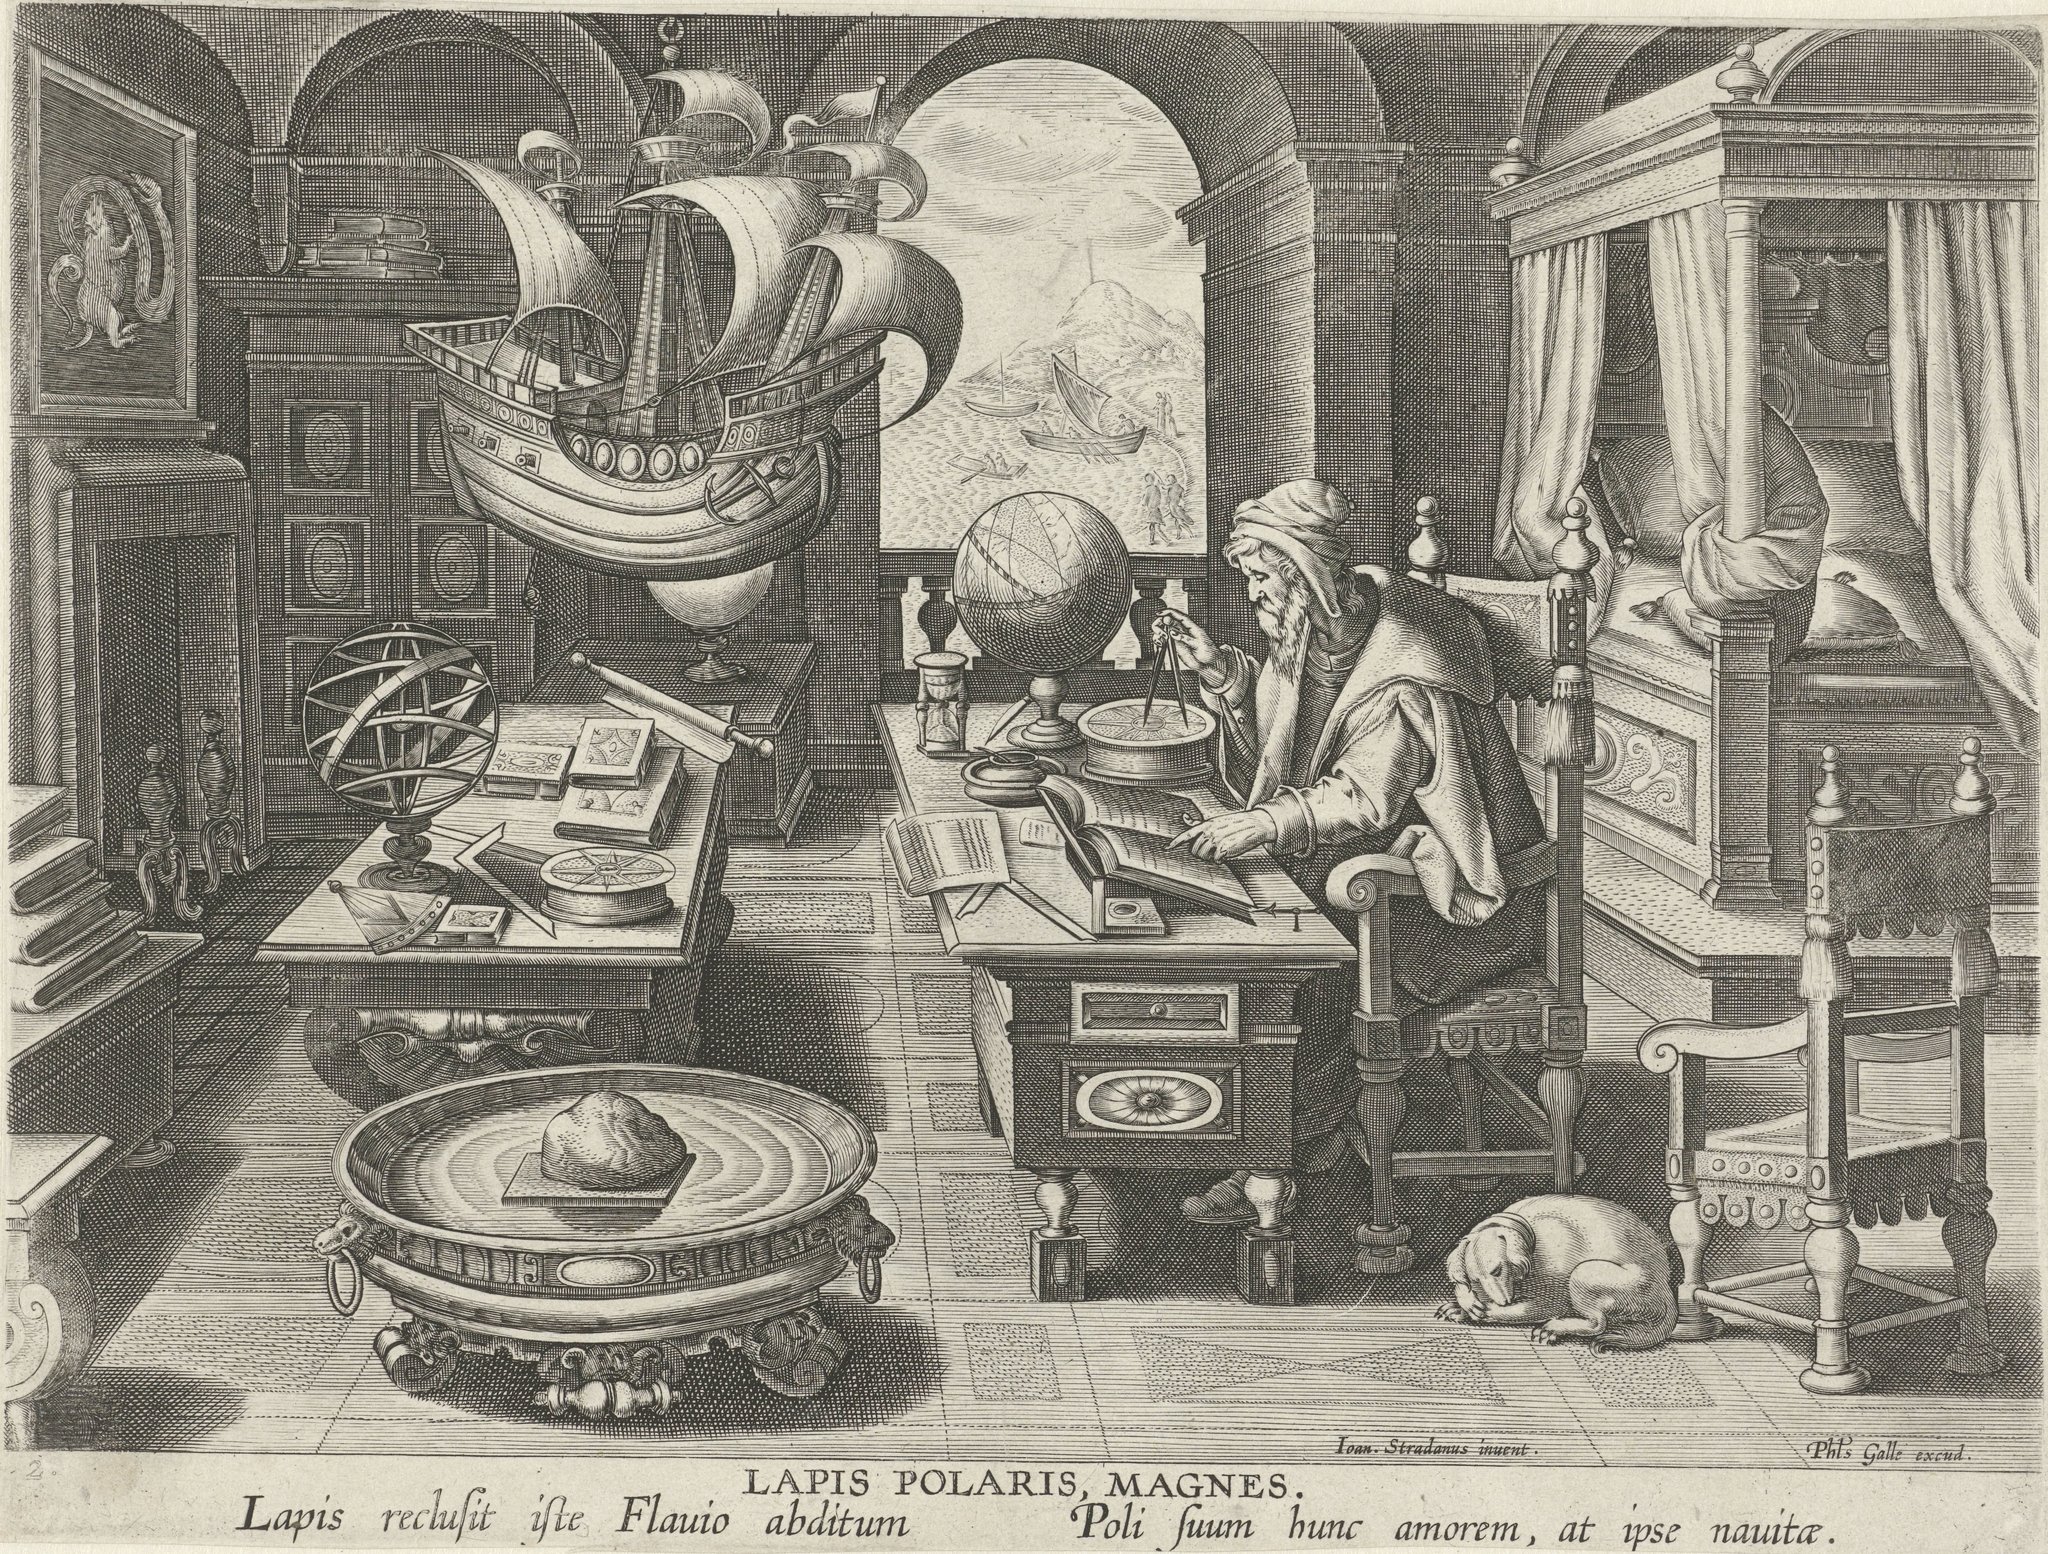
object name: print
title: Lapis Polaris, Magnes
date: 1589-1593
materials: paper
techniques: engraving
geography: florence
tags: amalfi, scholar in his study, laboratory apparatus and equipment, compass, medicament, medicine, invention, discovery ~ science and technology, ship-model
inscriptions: collector's mark: Lugt 2228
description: De wiskundige Flavio Goija, volgens legende de uitvinder van het kompas. zit in zijn studeerkamer en maakt met zijn passer enkele berekeningen. Op zijn werktafel allerlei wetenschappelijke instrumenten. Een maquette van een galjoen hangt van het plafond. De prent heeft een Latijns onderschrift en maakt deel uit van een negentiendelige serie over nieuwe uitvindingen en ontdekkingen.